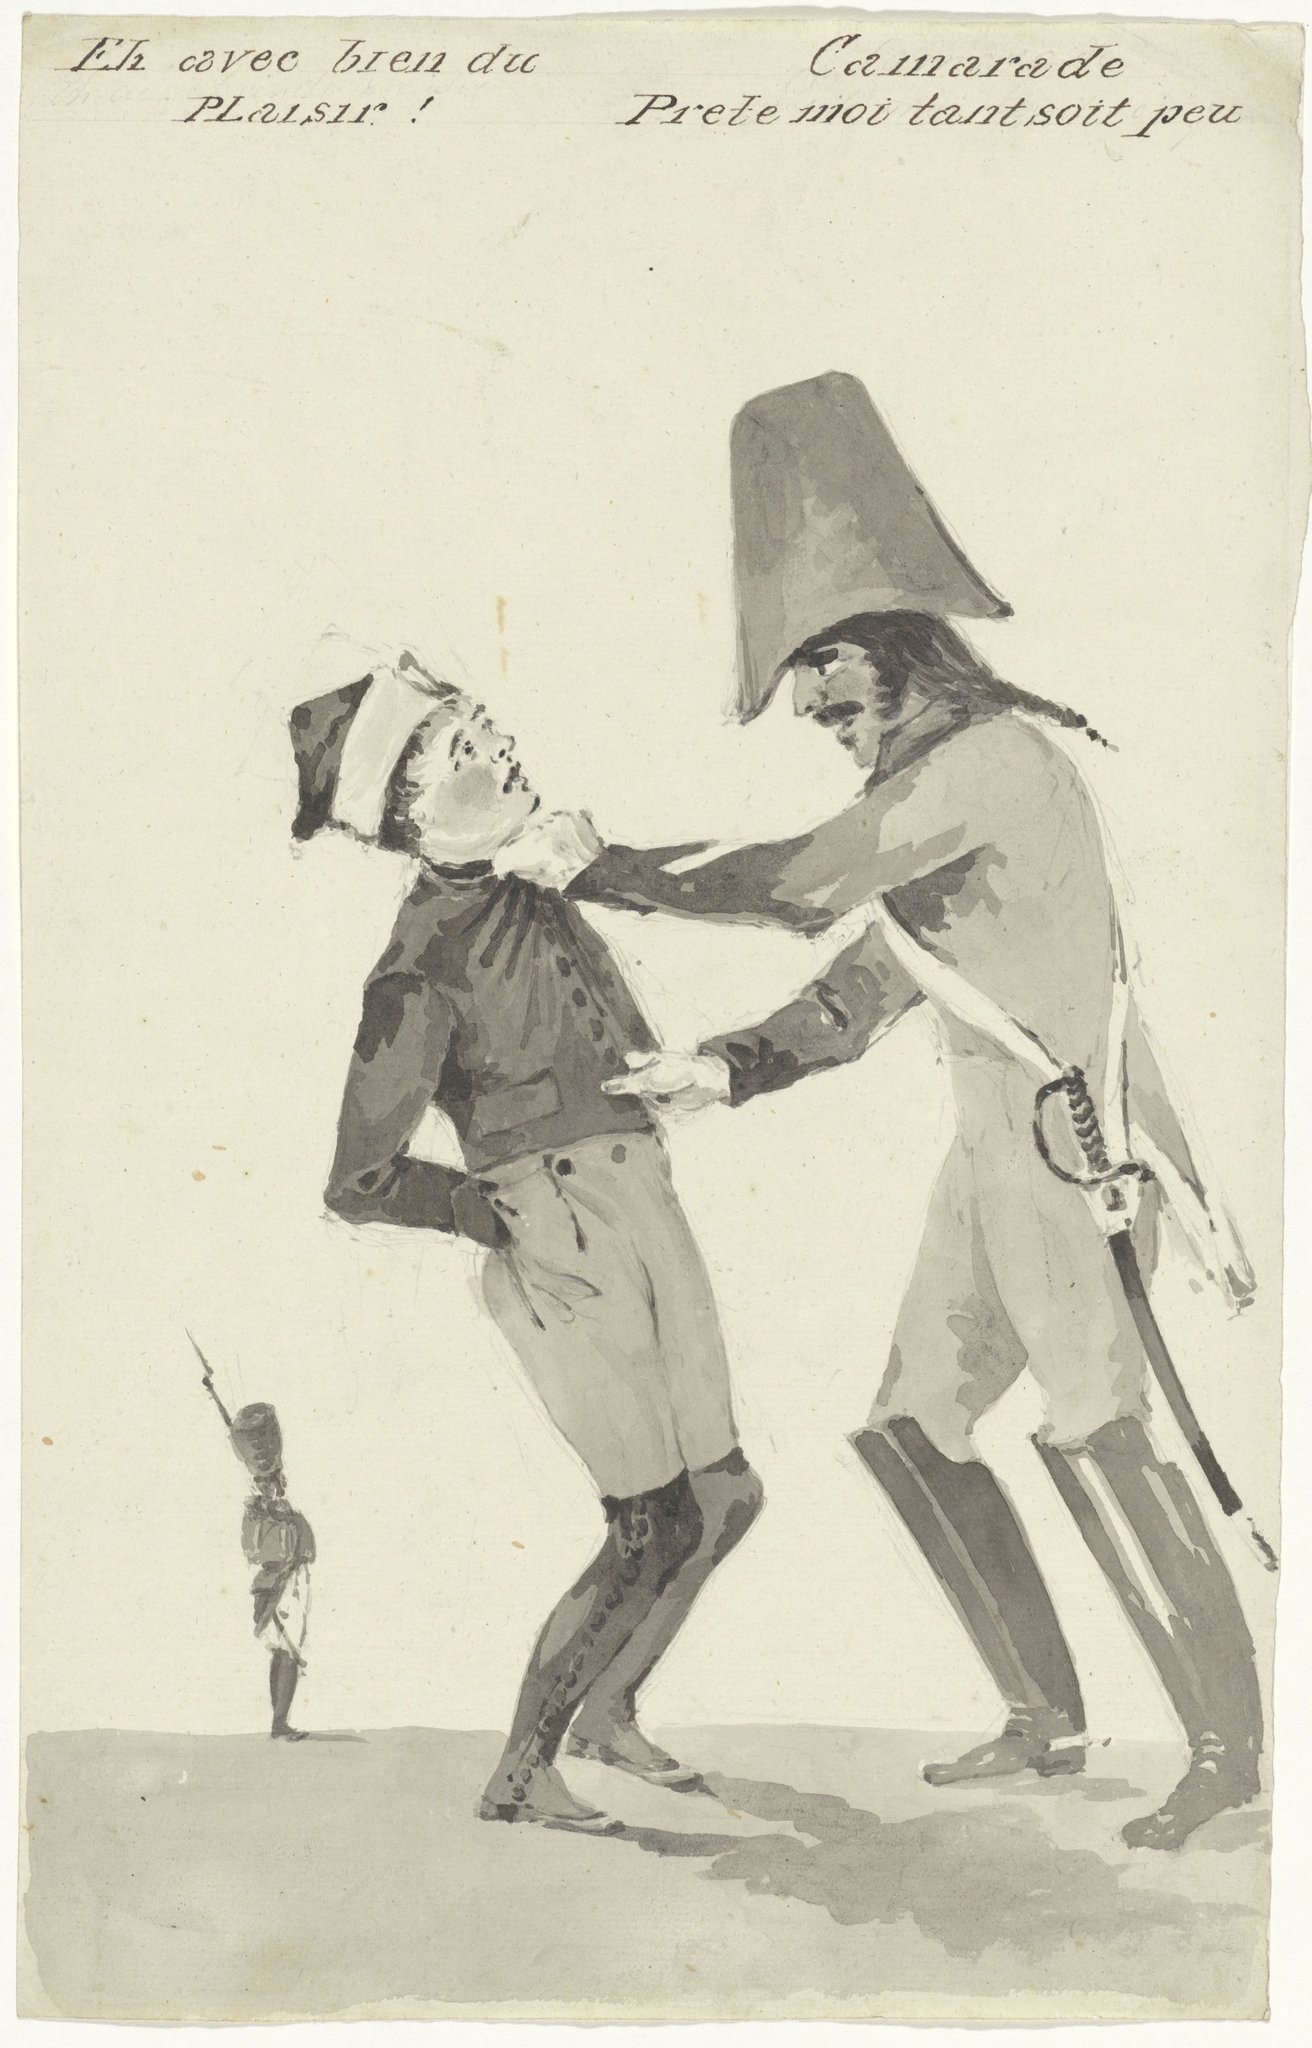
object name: drawing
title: Soldaat met jongen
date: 1811-1873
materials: paper, pencil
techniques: brush